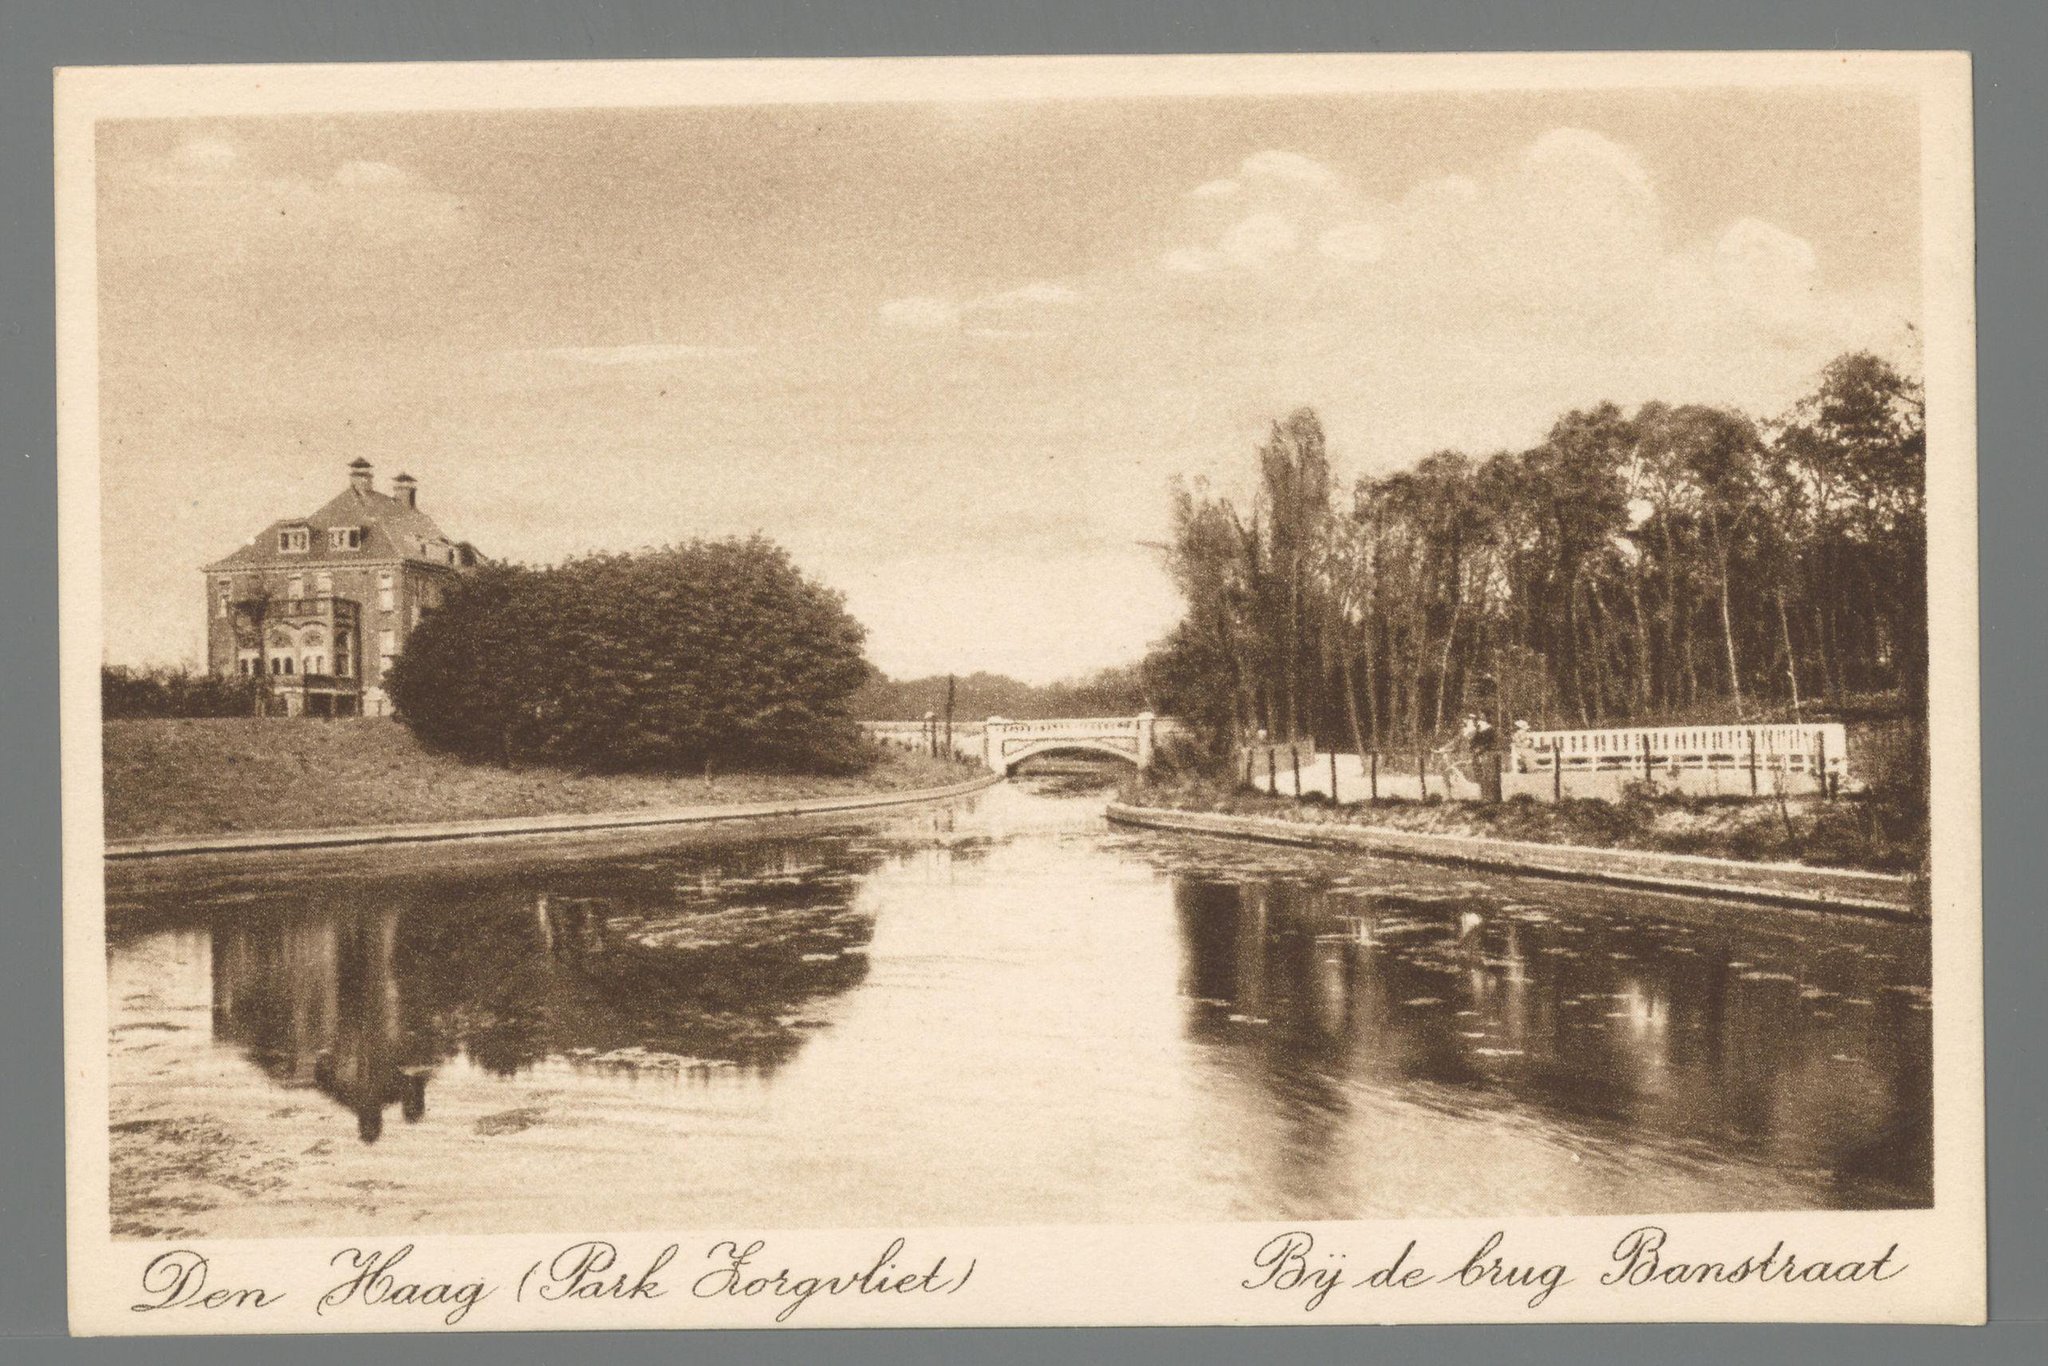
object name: ansichtkaart, prentbriefkaart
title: Bij de brug Banstraat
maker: Anonymous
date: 1913-1930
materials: cardboard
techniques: rotogravure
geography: the hague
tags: park, canals, waters (in city), bridge in city across river, canal, etc.